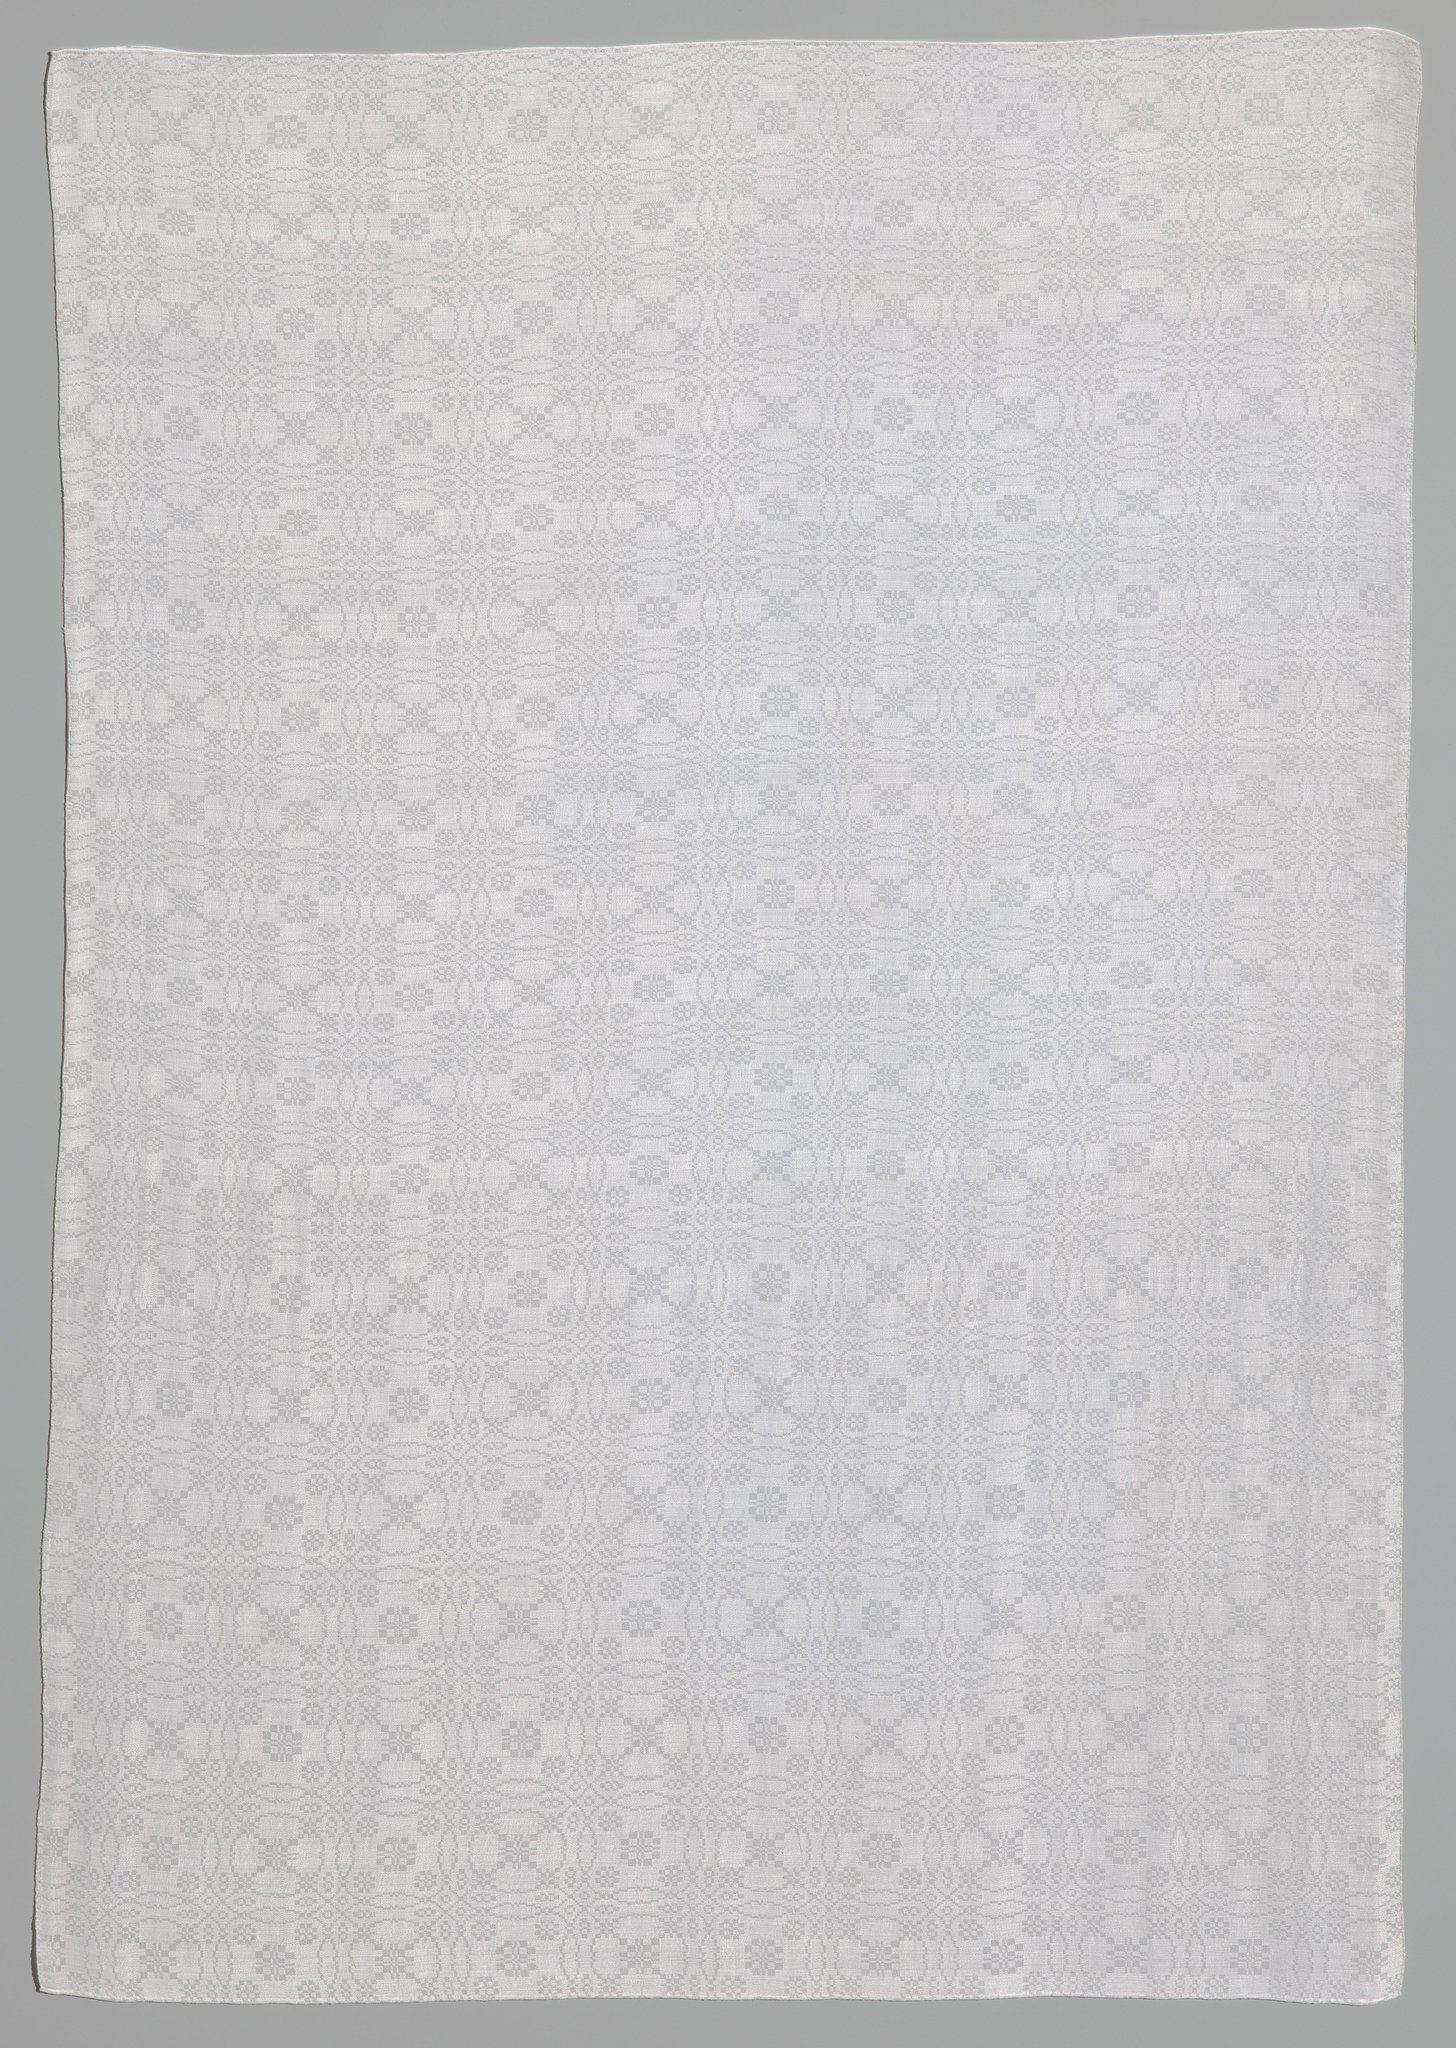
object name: napkin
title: Servet van linnen met pellenpatroon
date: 1660-1700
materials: linen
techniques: peeled fabric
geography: northern netherlands